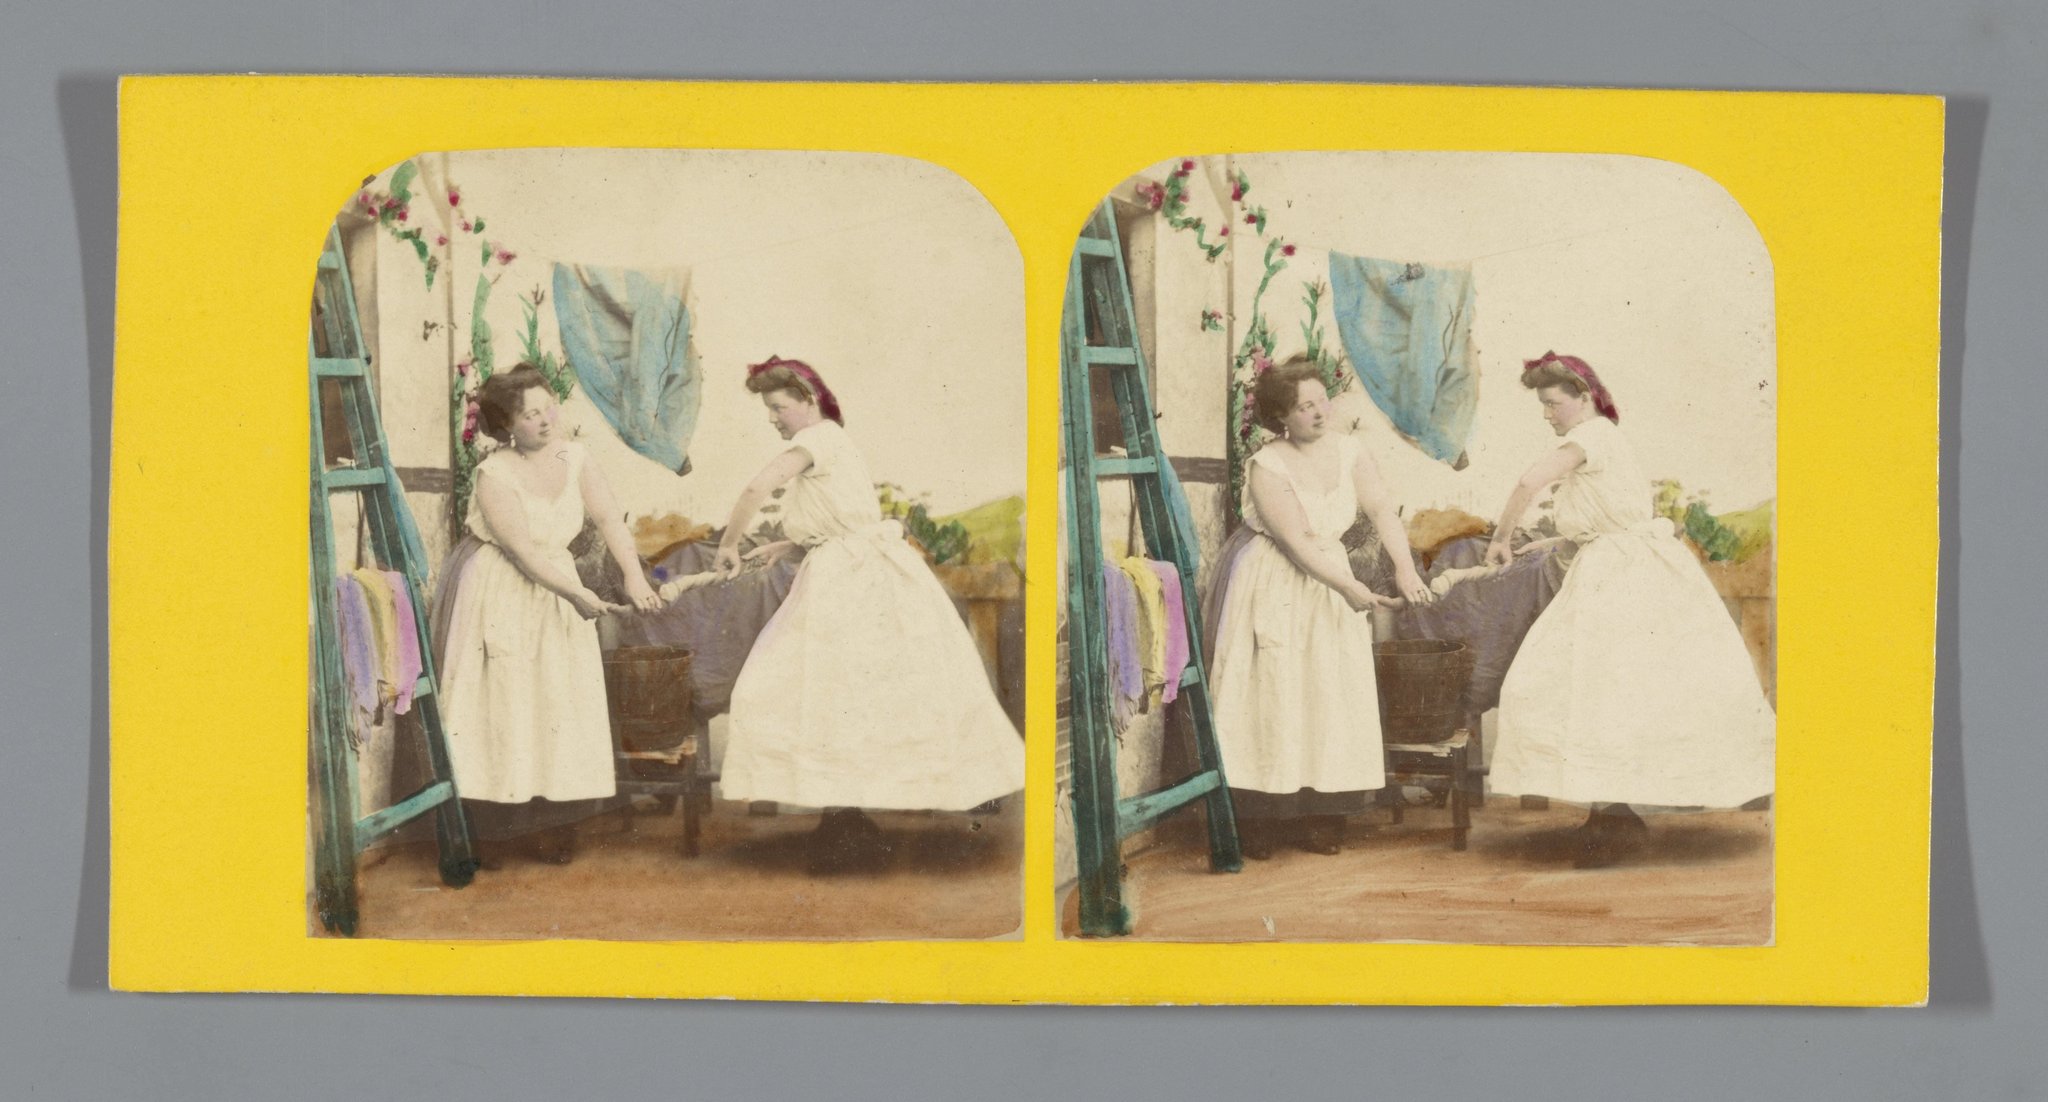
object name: stereograph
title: Twee vrouwen wringen samen wasgoed uit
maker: Anonymous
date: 1852-1858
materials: cardboard, paper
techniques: albumen print, hand coloring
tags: adult woman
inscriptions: inscription: ‘co/ 5005’